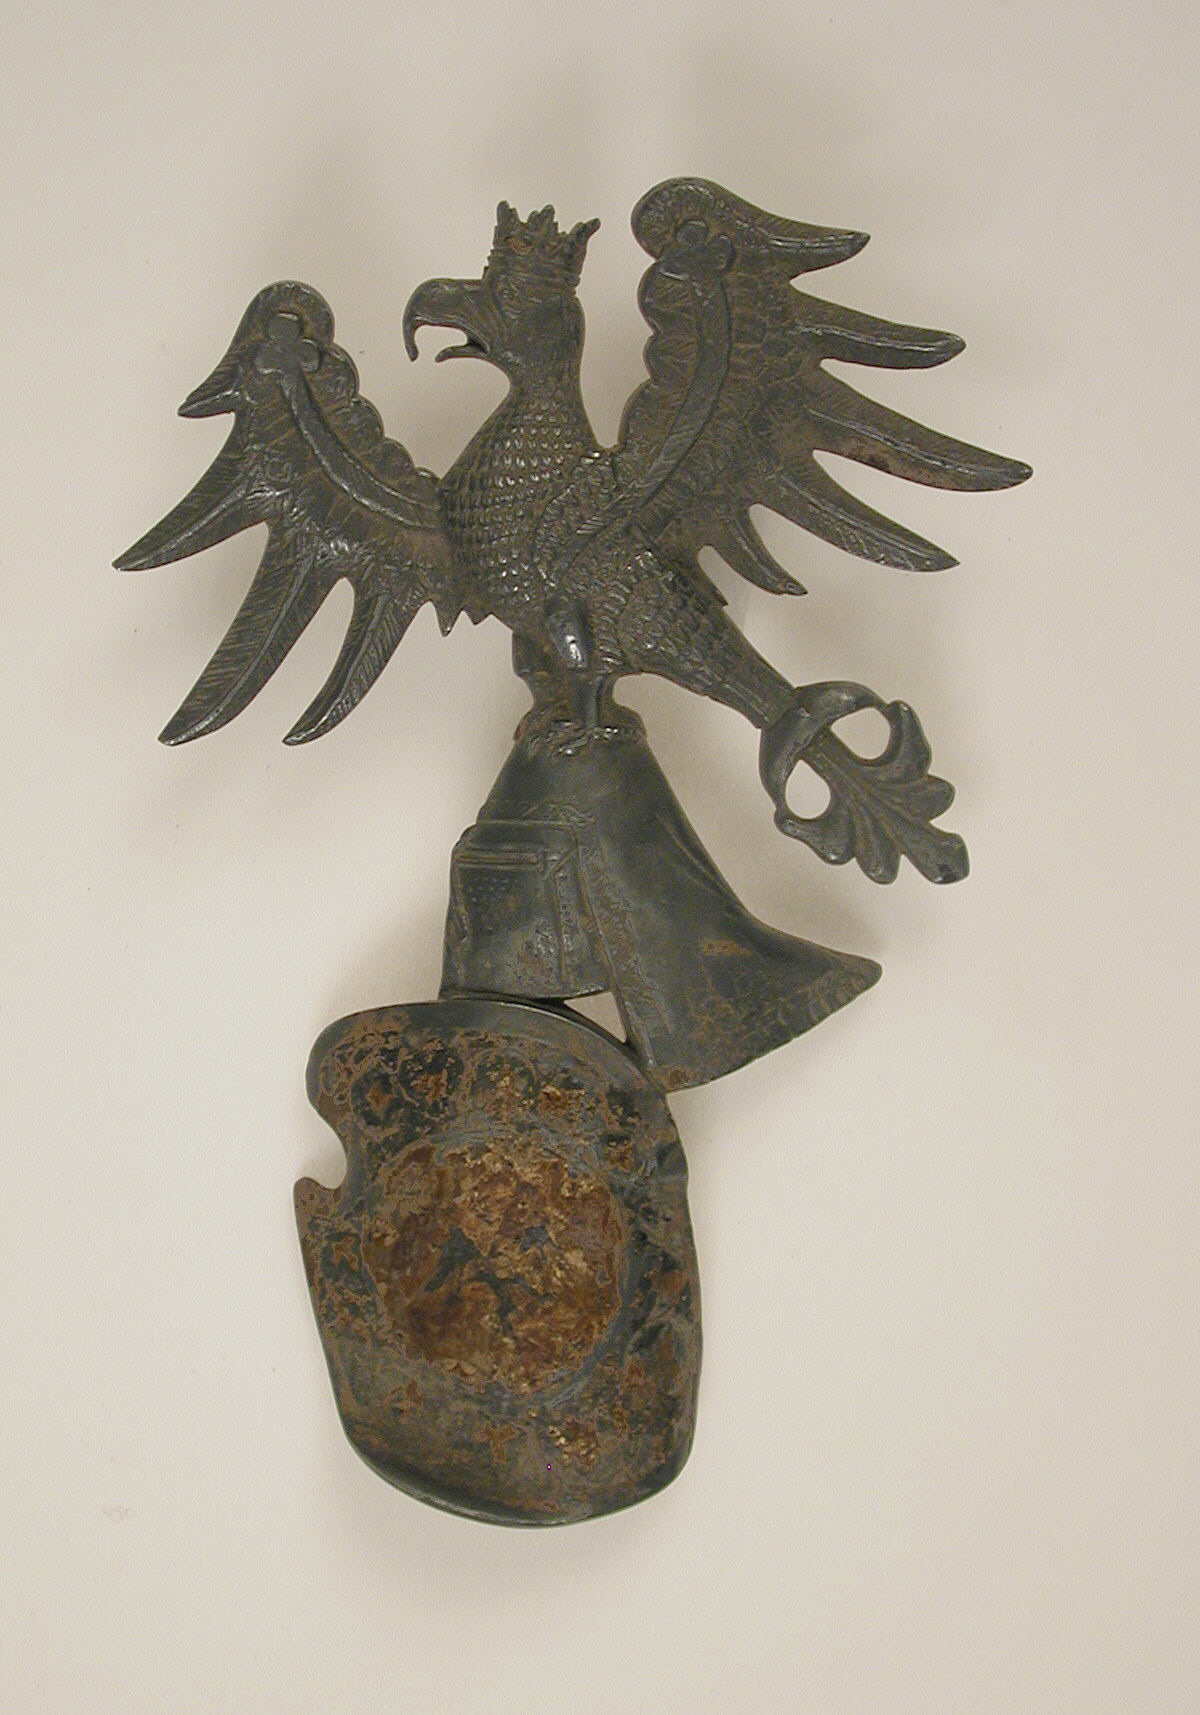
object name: escutcheon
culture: polish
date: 1901-1933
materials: enamel, silver gilt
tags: eagles